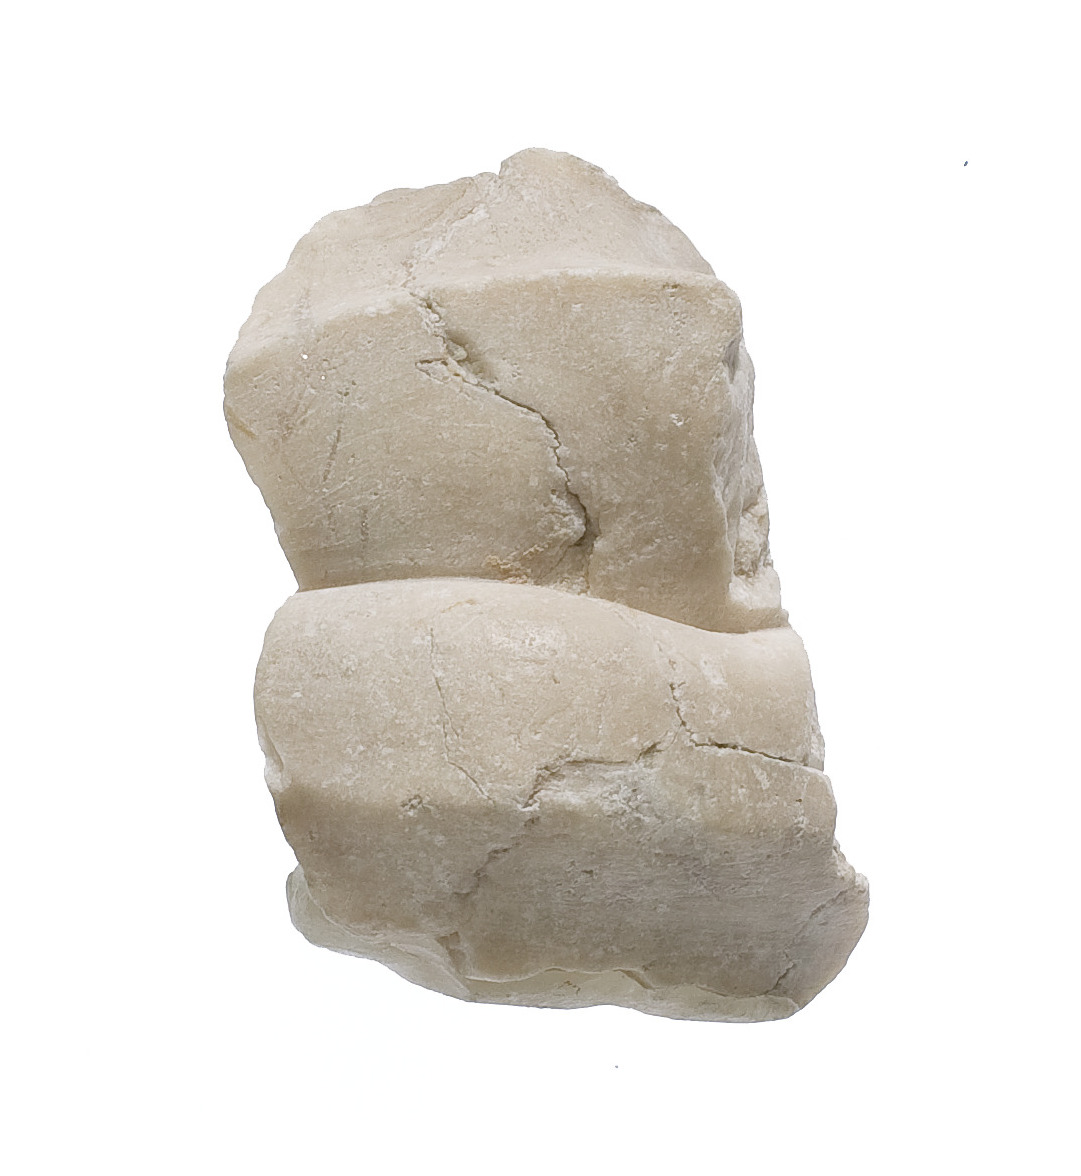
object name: head of akhenaten or nefertiti, lip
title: Lips from a statue of king or queen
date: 1353-1336 BCE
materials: limestone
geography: egypt